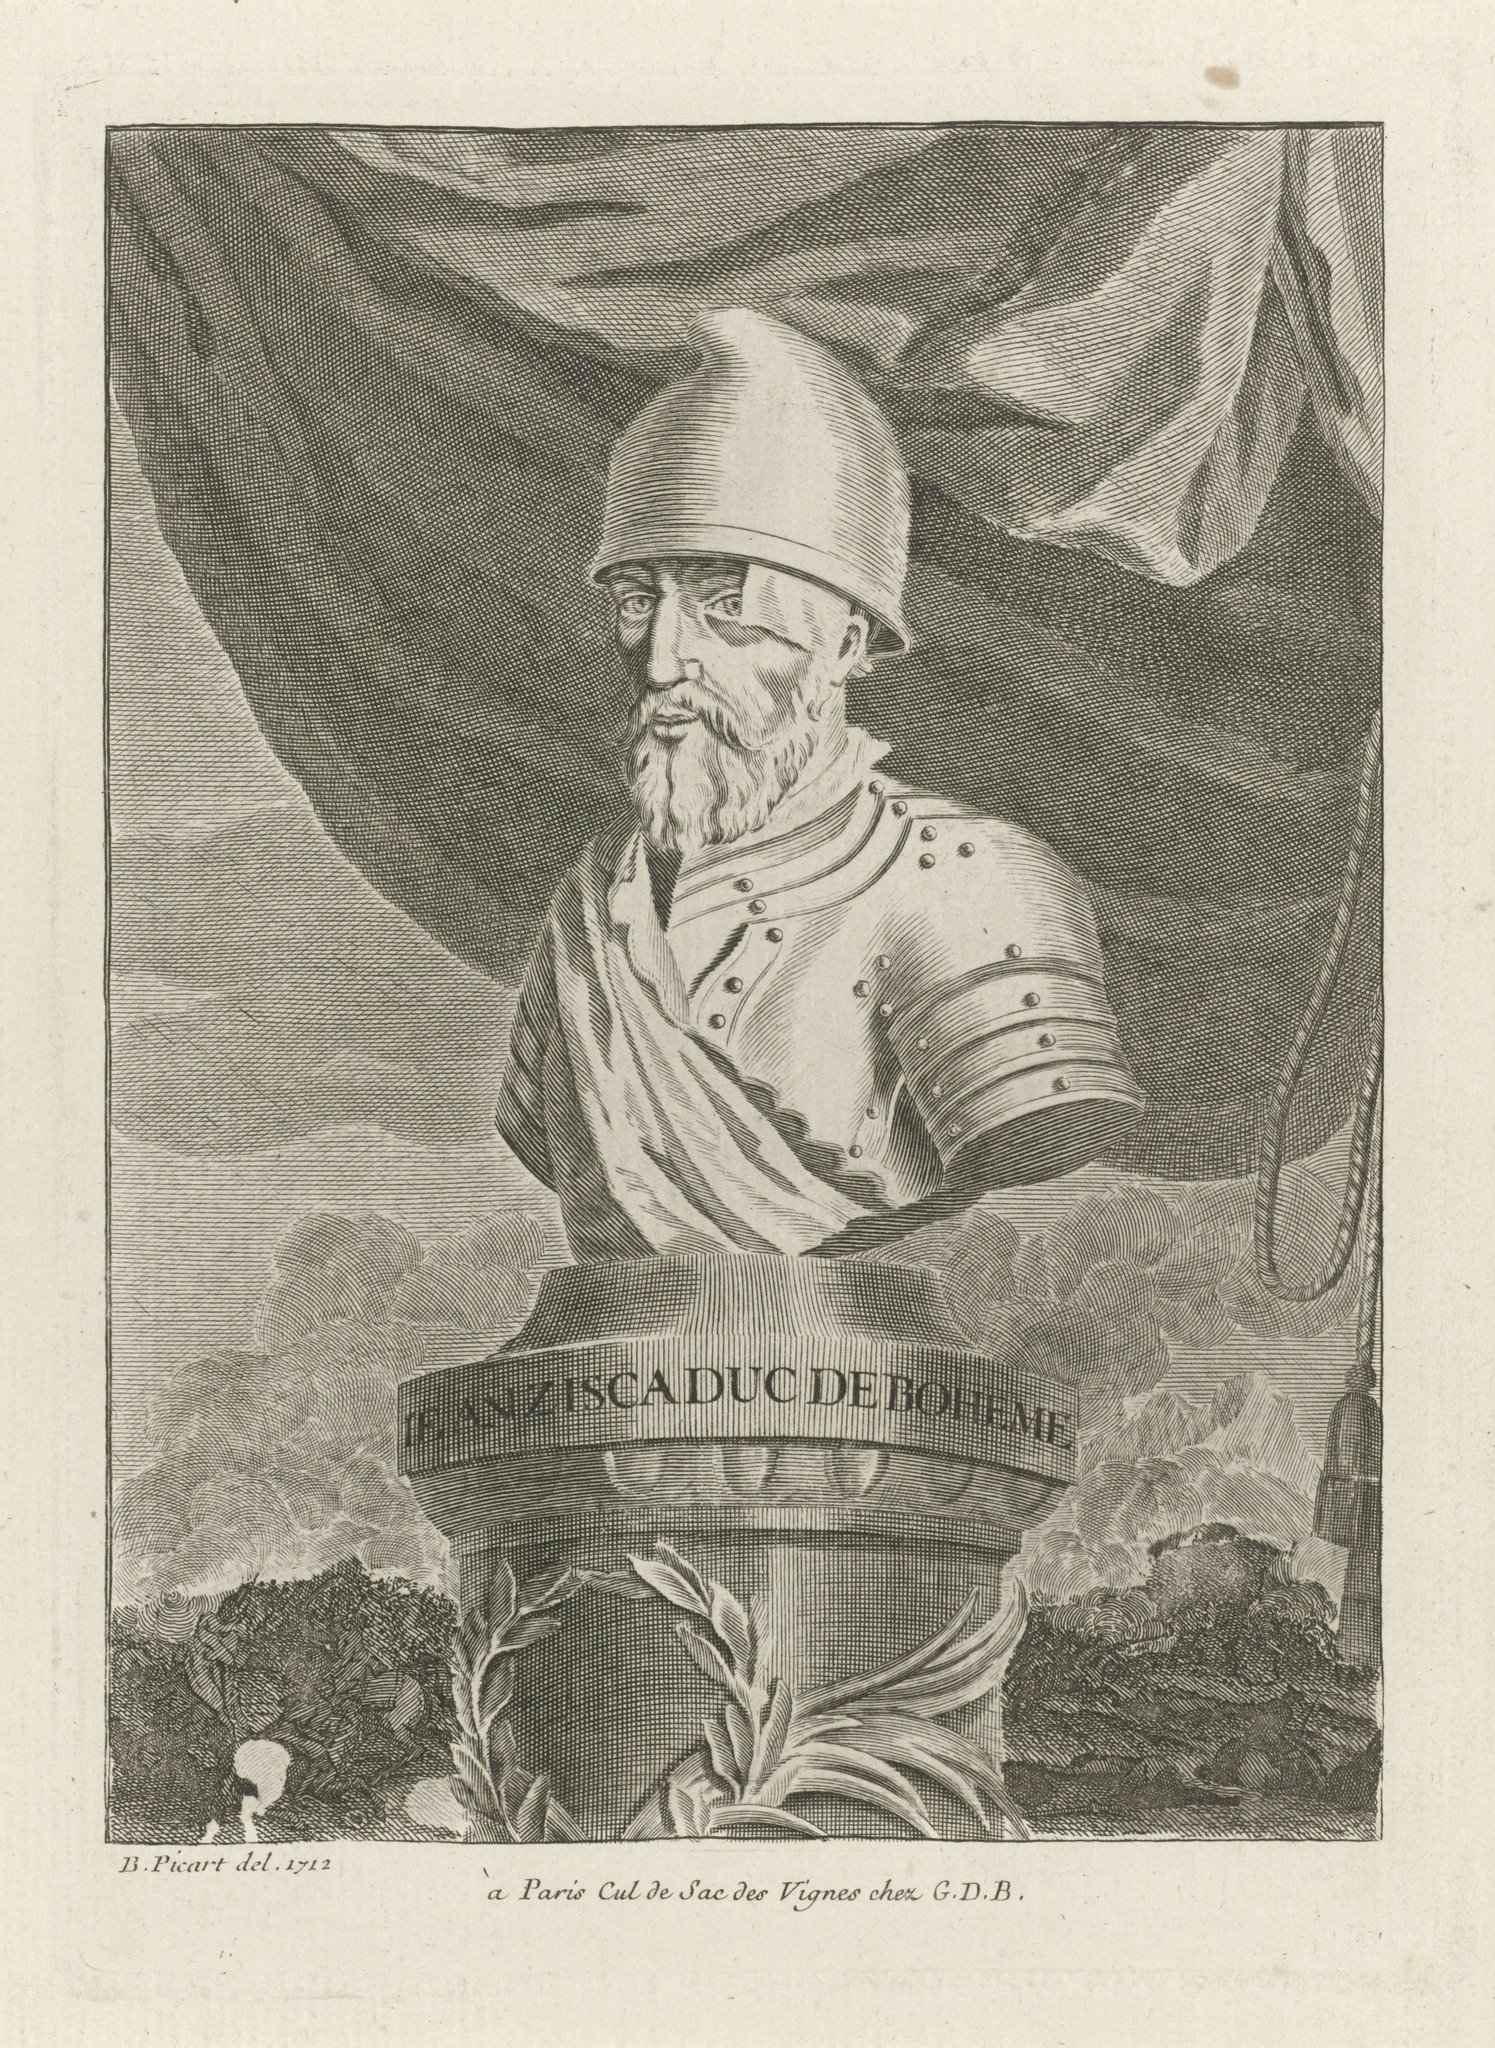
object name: print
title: Buste van Jan Zizka, hertog van Bohemen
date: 1712-1762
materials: paper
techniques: engraving, etching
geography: amsterdam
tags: commander-in-chief, general, marshal, battle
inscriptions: collector's mark: Lugt 2228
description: Buste van Jan Žižka z Trocnova a Kalicha (Jan Zizka), leider van de Hussieten en hertog van Bohemen. Op de achtergrond een veldslag.